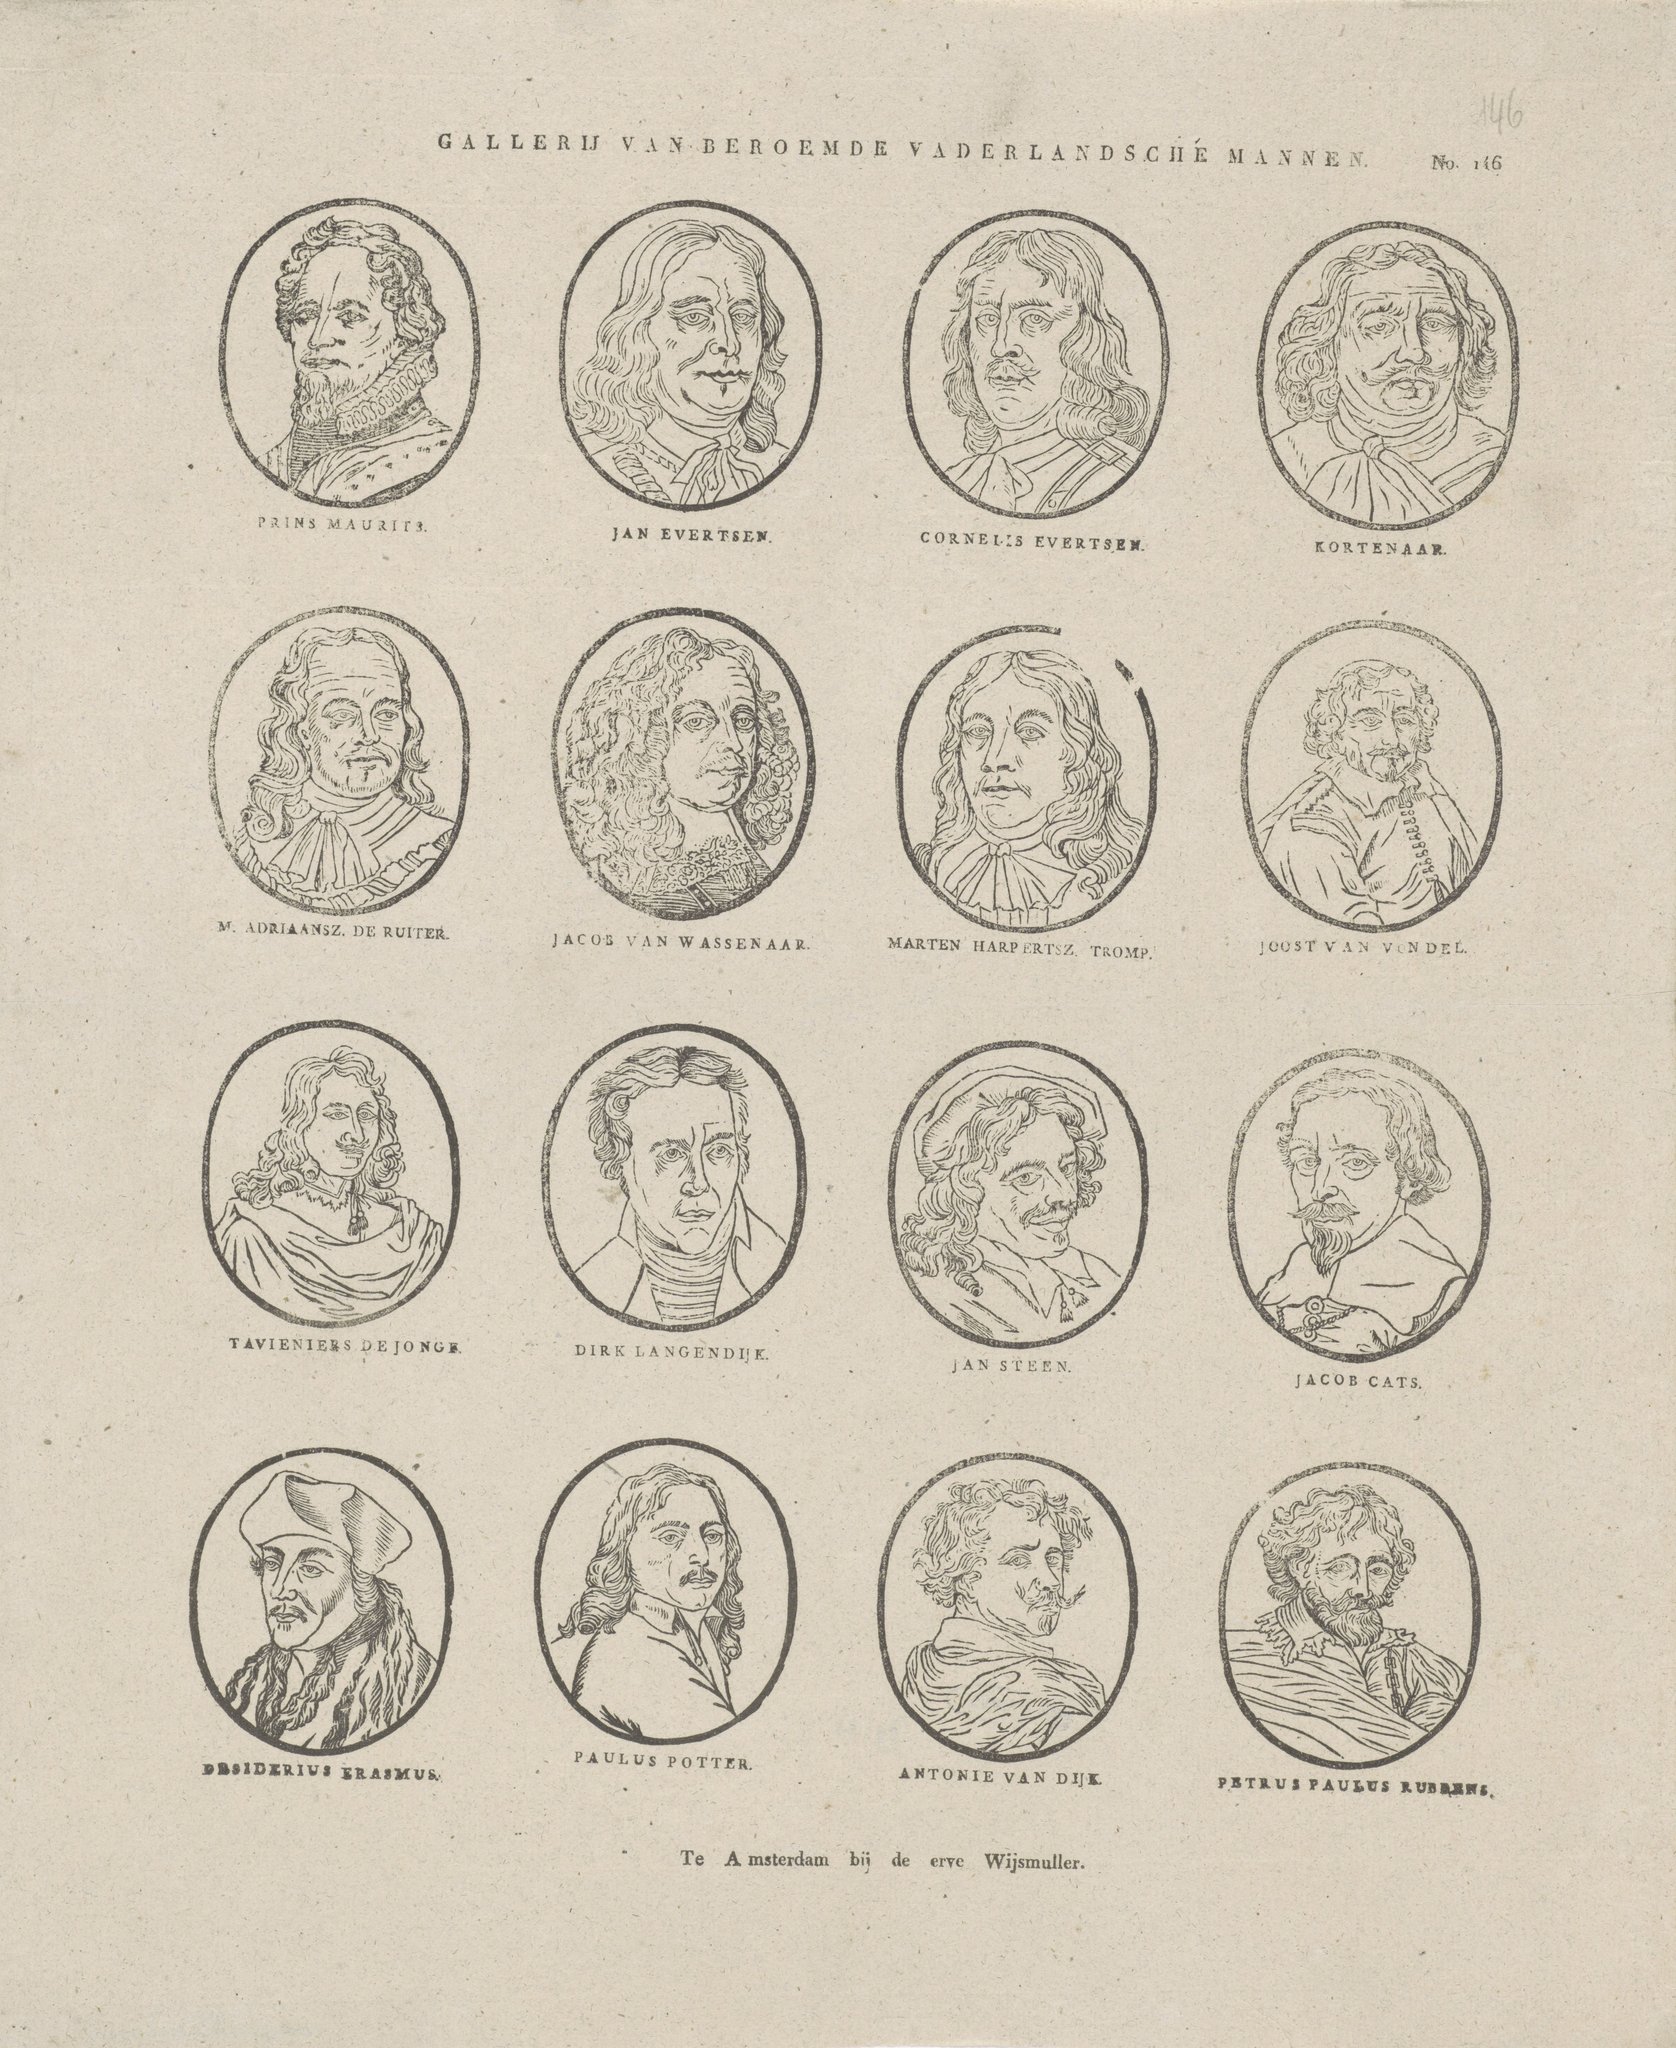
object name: popular print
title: Gallerij van beroemde vaderlandsche mannen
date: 1791-1838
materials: paper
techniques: letterpress printing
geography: amsterdam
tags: dirk langendijk, enkhuizen, paulus potter, flushing, cornelis evertsen (1628-1679), jan havicksz. steen, rotterdam, desiderius erasmus, michiel adriaenszoon de ruyter, jacob baron van wassenaer heer van obdam, maurice (prince of orange), the hague, jacob cats (1577-1660), peter paul rubens, antwerp, london, painter, print maker, draughtsman, anthony van dyck, cologne, amsterdam, joost van den vondel, brielle, maarten harpertszoon tromp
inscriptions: collector's mark: Lugt 2760, collector's mark: Lugt 2228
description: Blad met 16 ovale portretten van beroemde Nederlandse mannen, waaronder Prins Maurits, Joost van den Vondel, Jan Steen, Erasmus en Peter Paul Rubens. Onder elke afbeelding een onderschrift. Genummerd rechtsboven: No. 146.